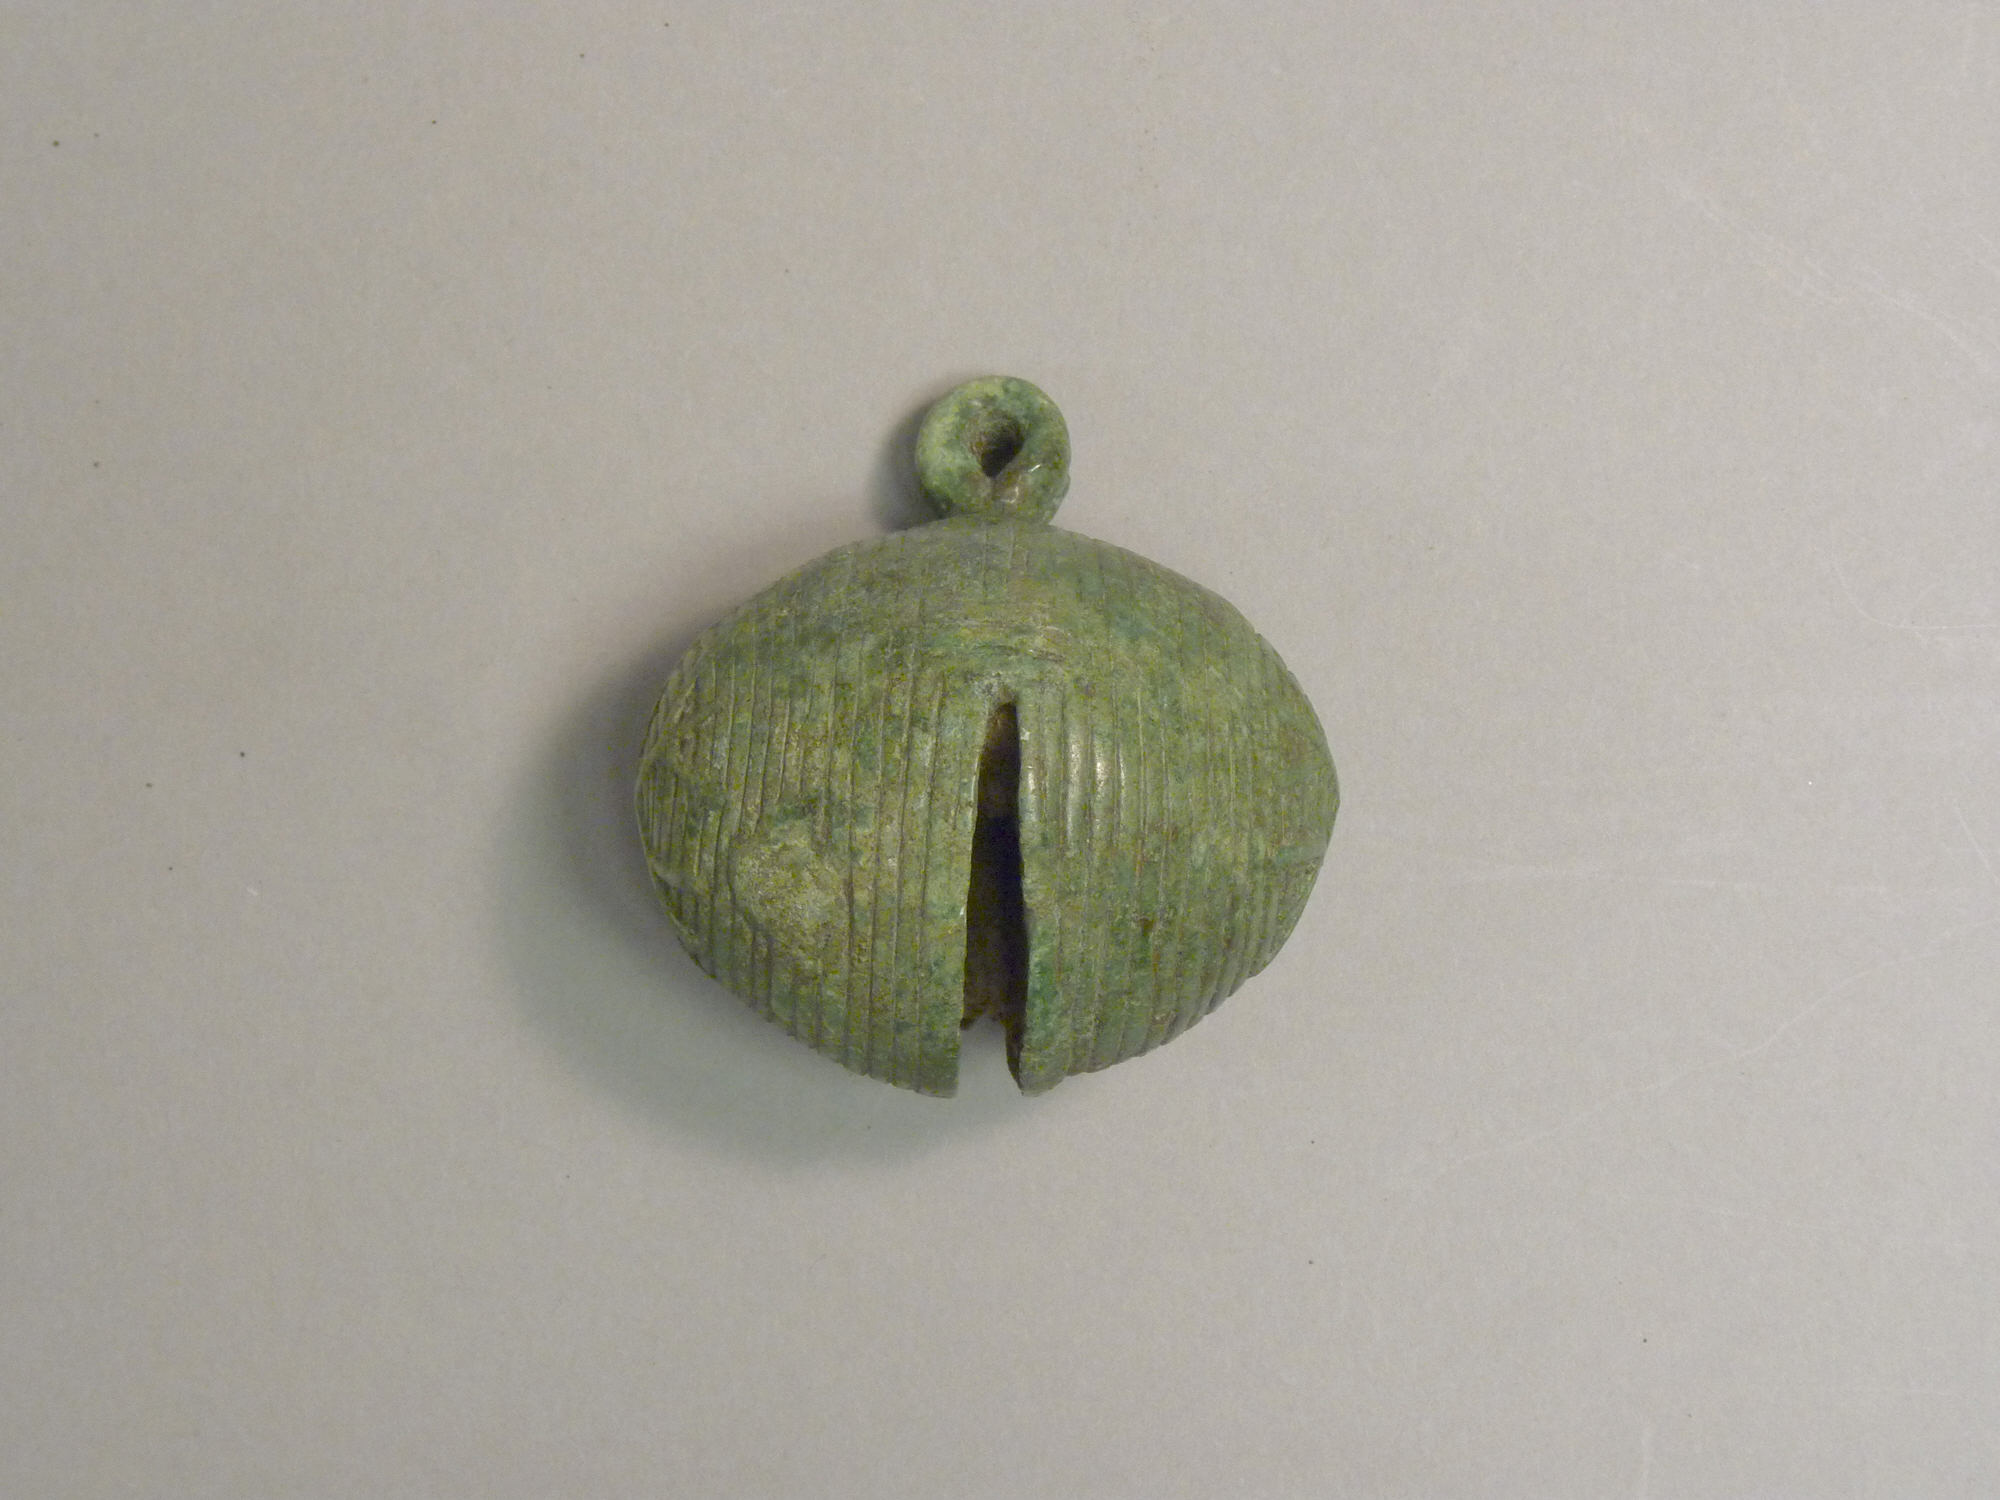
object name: ball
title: Split Ball with Striated Surface and Star Motifs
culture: indonesian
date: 500 BCE-300 CE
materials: bronze